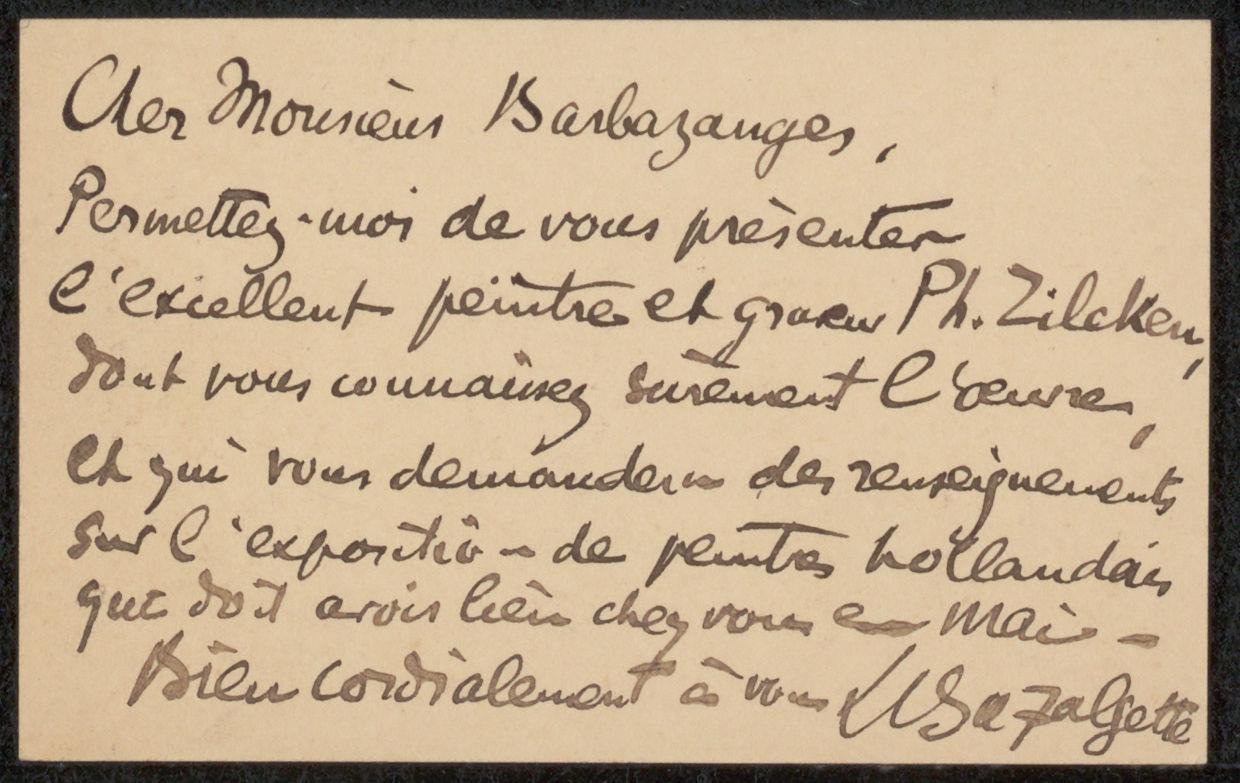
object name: visiting card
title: Visitekaartje aan de heer Barbazanges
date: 1883-1928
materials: cardboard, ink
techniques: pen, printing, writing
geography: paris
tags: the hague, draughtsman, philip zilcken, the graphic arts, painting (including book-illumination, miniature-painting), temporary exhibition, 'salon'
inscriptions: collector's mark: ‘RPK’